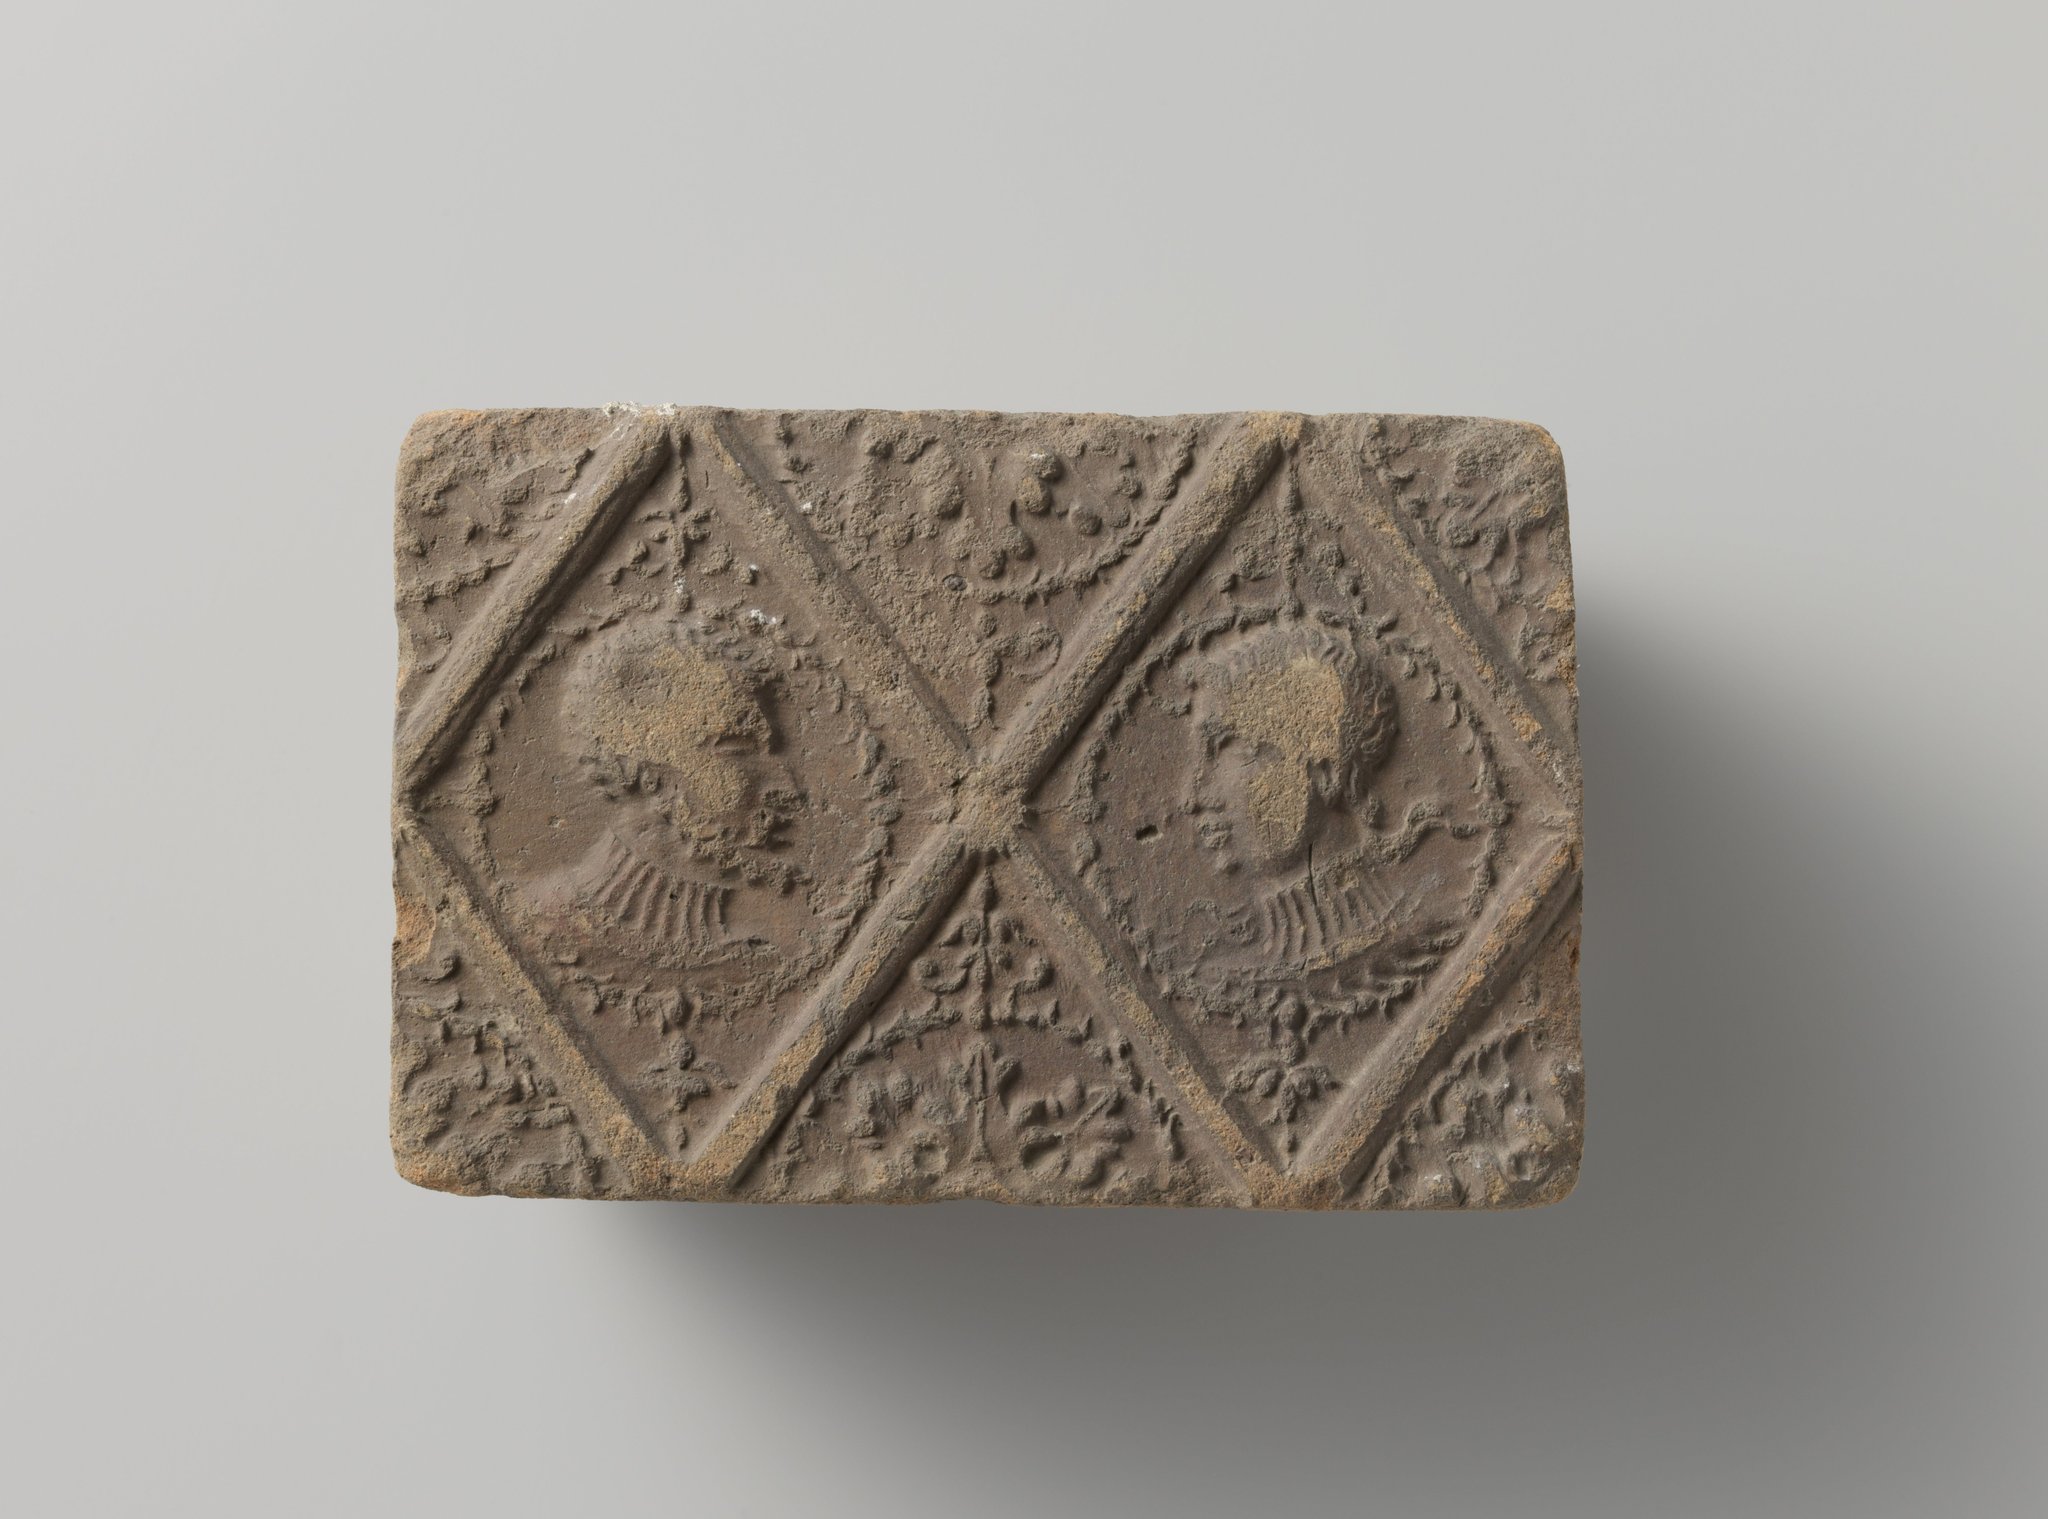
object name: architectural element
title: Haardsteen met een voorstelling van een mannen- en vrouwenkop in twee geprofileerde ruiten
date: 1550-1599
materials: earthenware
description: haardsteen met een voorstelling van een mannen- en vrouwenkop en profil, geplaatst in twee geprofileerde ruiten. De halve en kwart ruiten aan de boven- en onderkant zijn opgevuld met bloemversieringen in lauwerkansen.